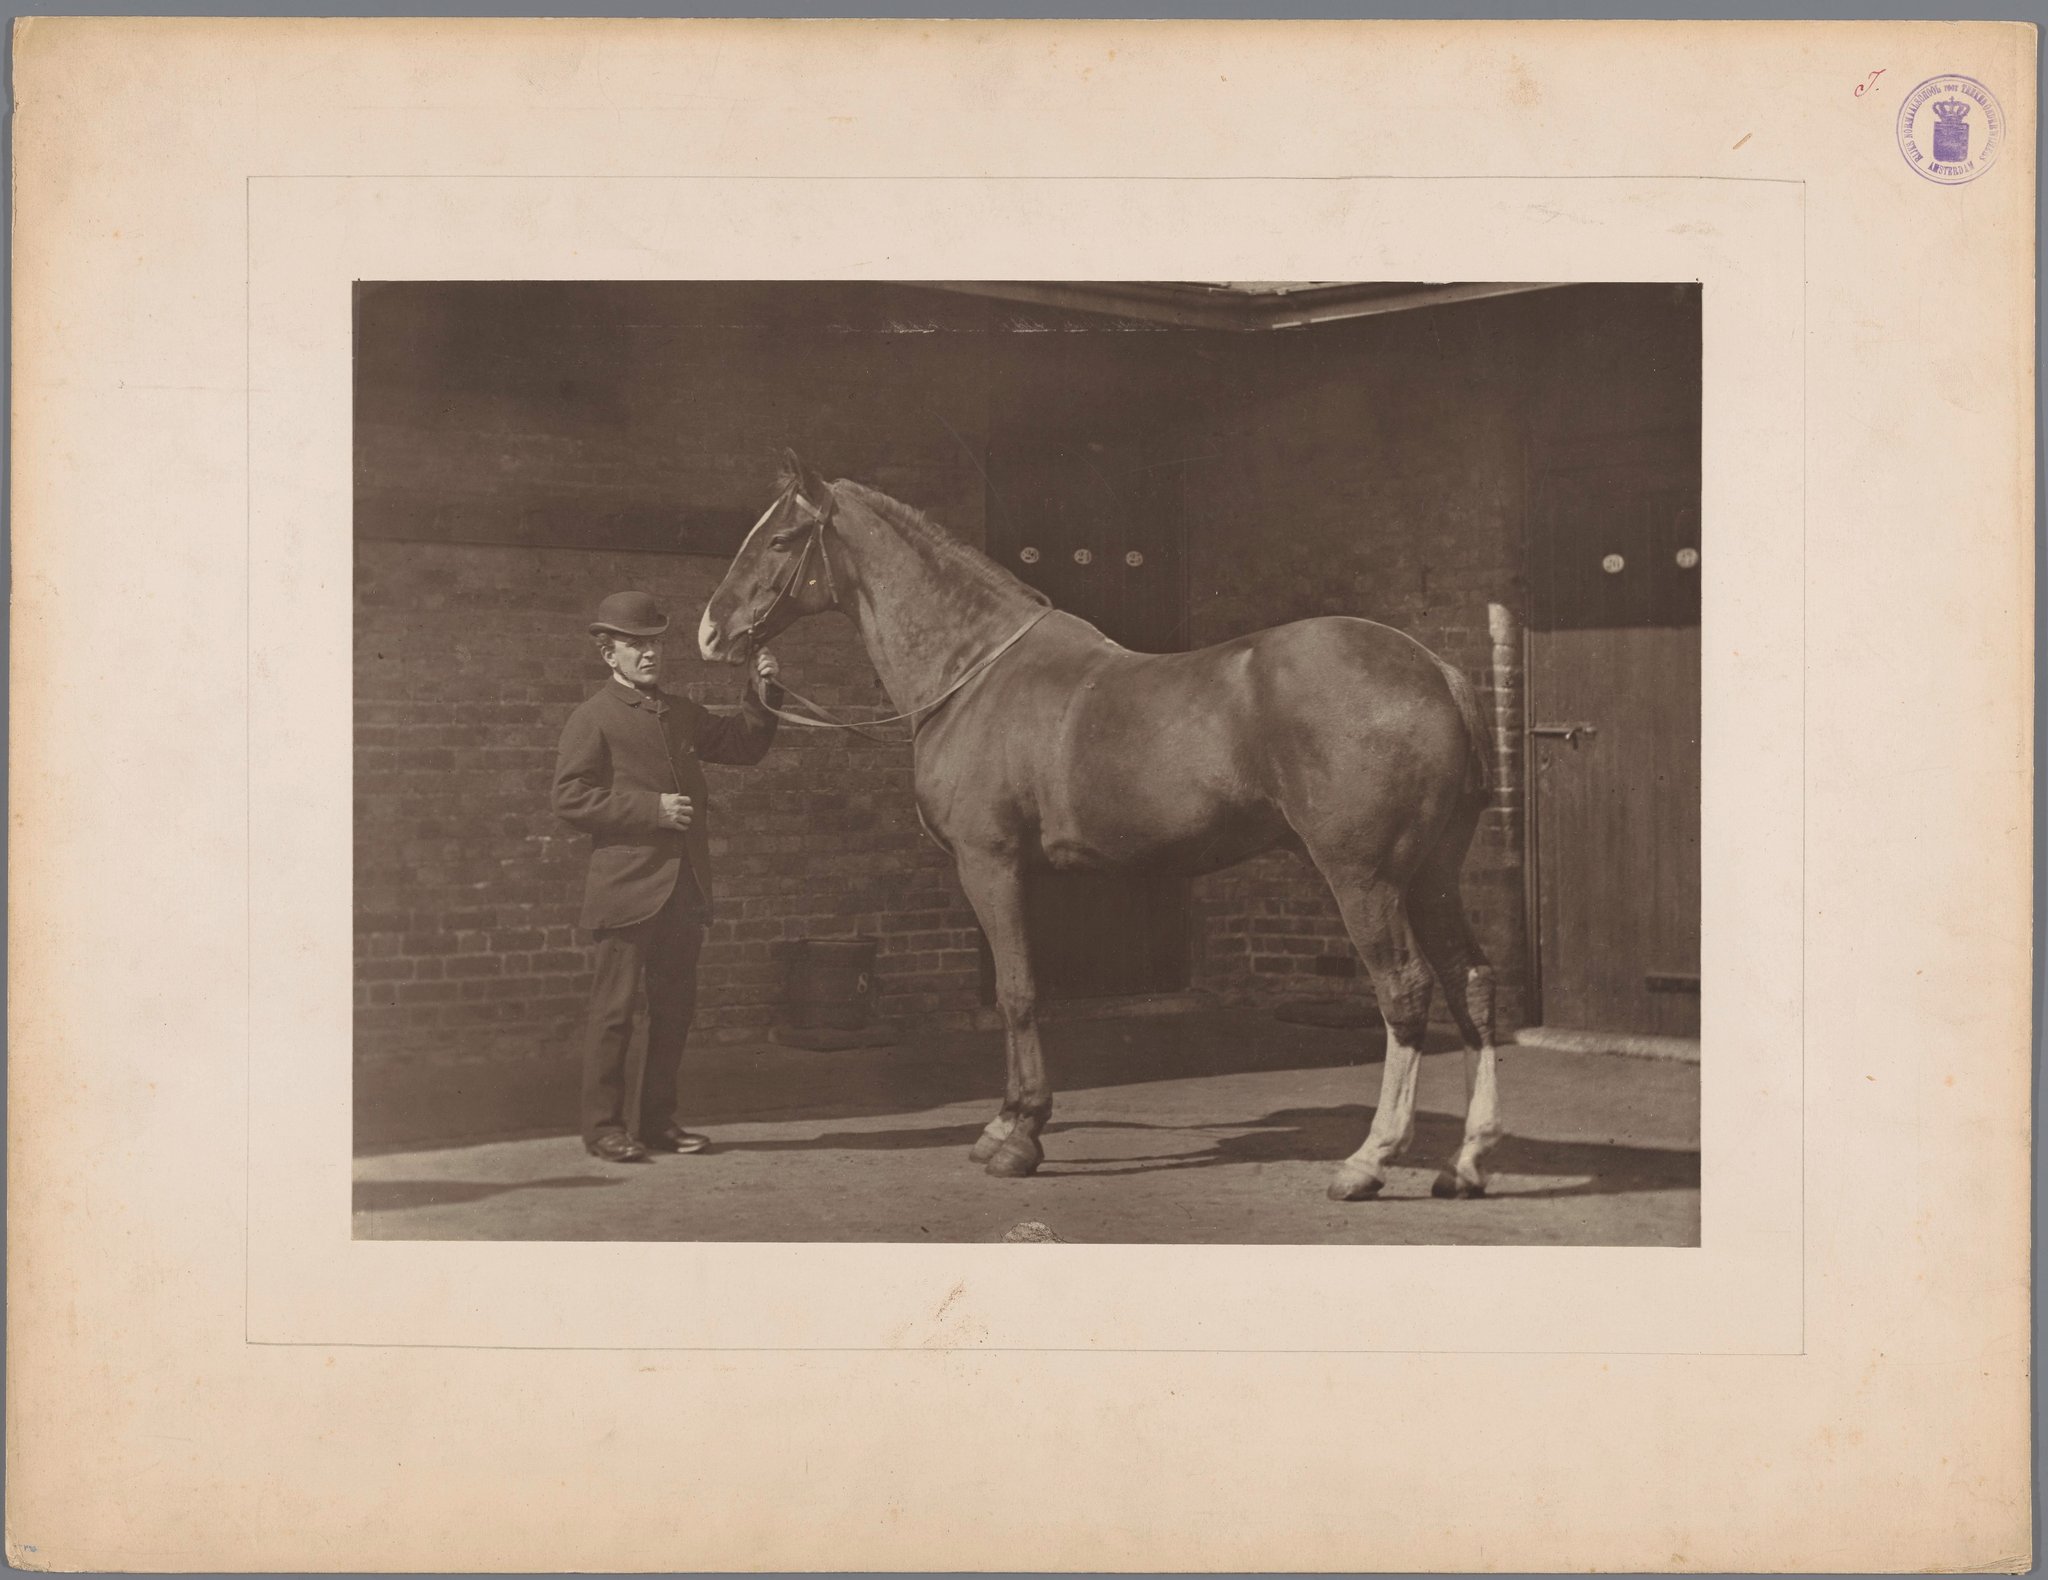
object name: photograph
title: Man met paard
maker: Anonymous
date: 1875-1900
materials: cardboard, photographic support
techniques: carbon print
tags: head-gear: hat, horse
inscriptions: inscription: ‘J.’, collector's mark: ‘RIJKS NORMAALSCHOOL VOOR TEEKENONDERWIJZERS AMSTERDAM’